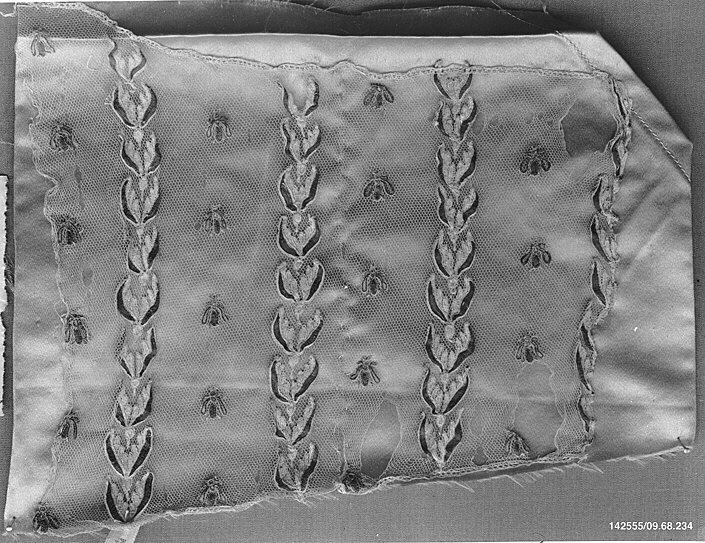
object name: piece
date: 1767-1800